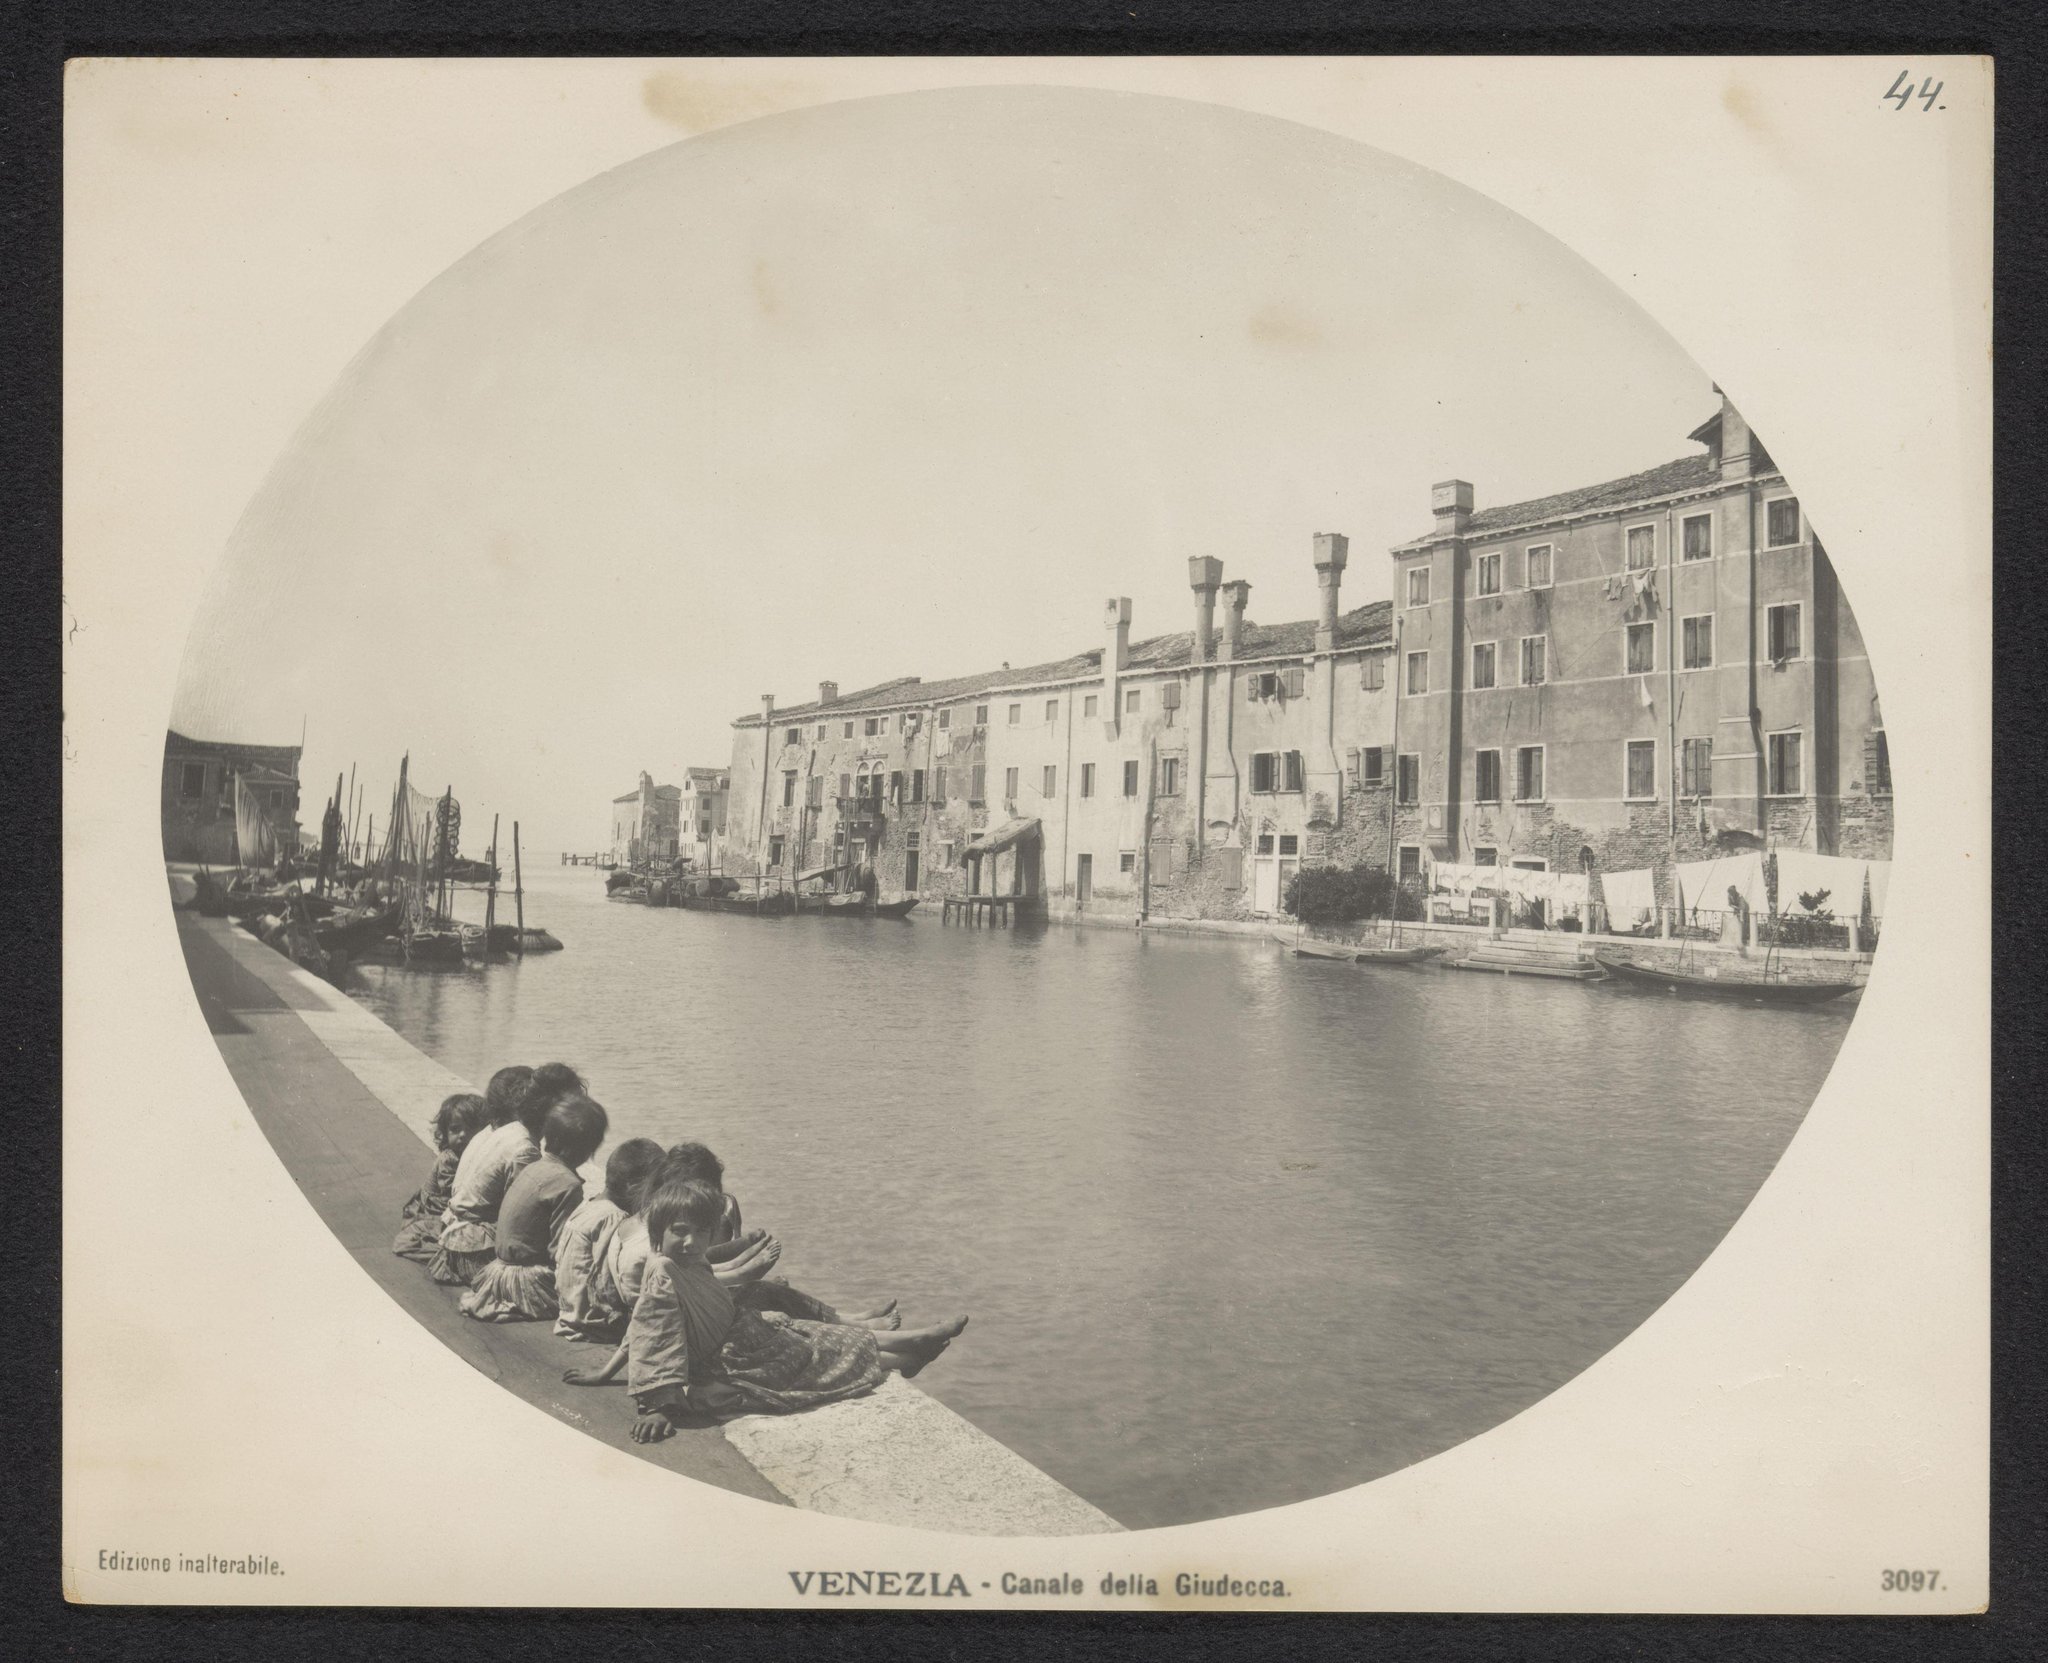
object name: photograph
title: Venezia - Canale della Giudecca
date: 1900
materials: cardboard, photographic support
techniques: gelatin silver print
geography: venice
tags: child, canal, quay, venice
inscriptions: number: ‘3097.’, number: ‘44.’